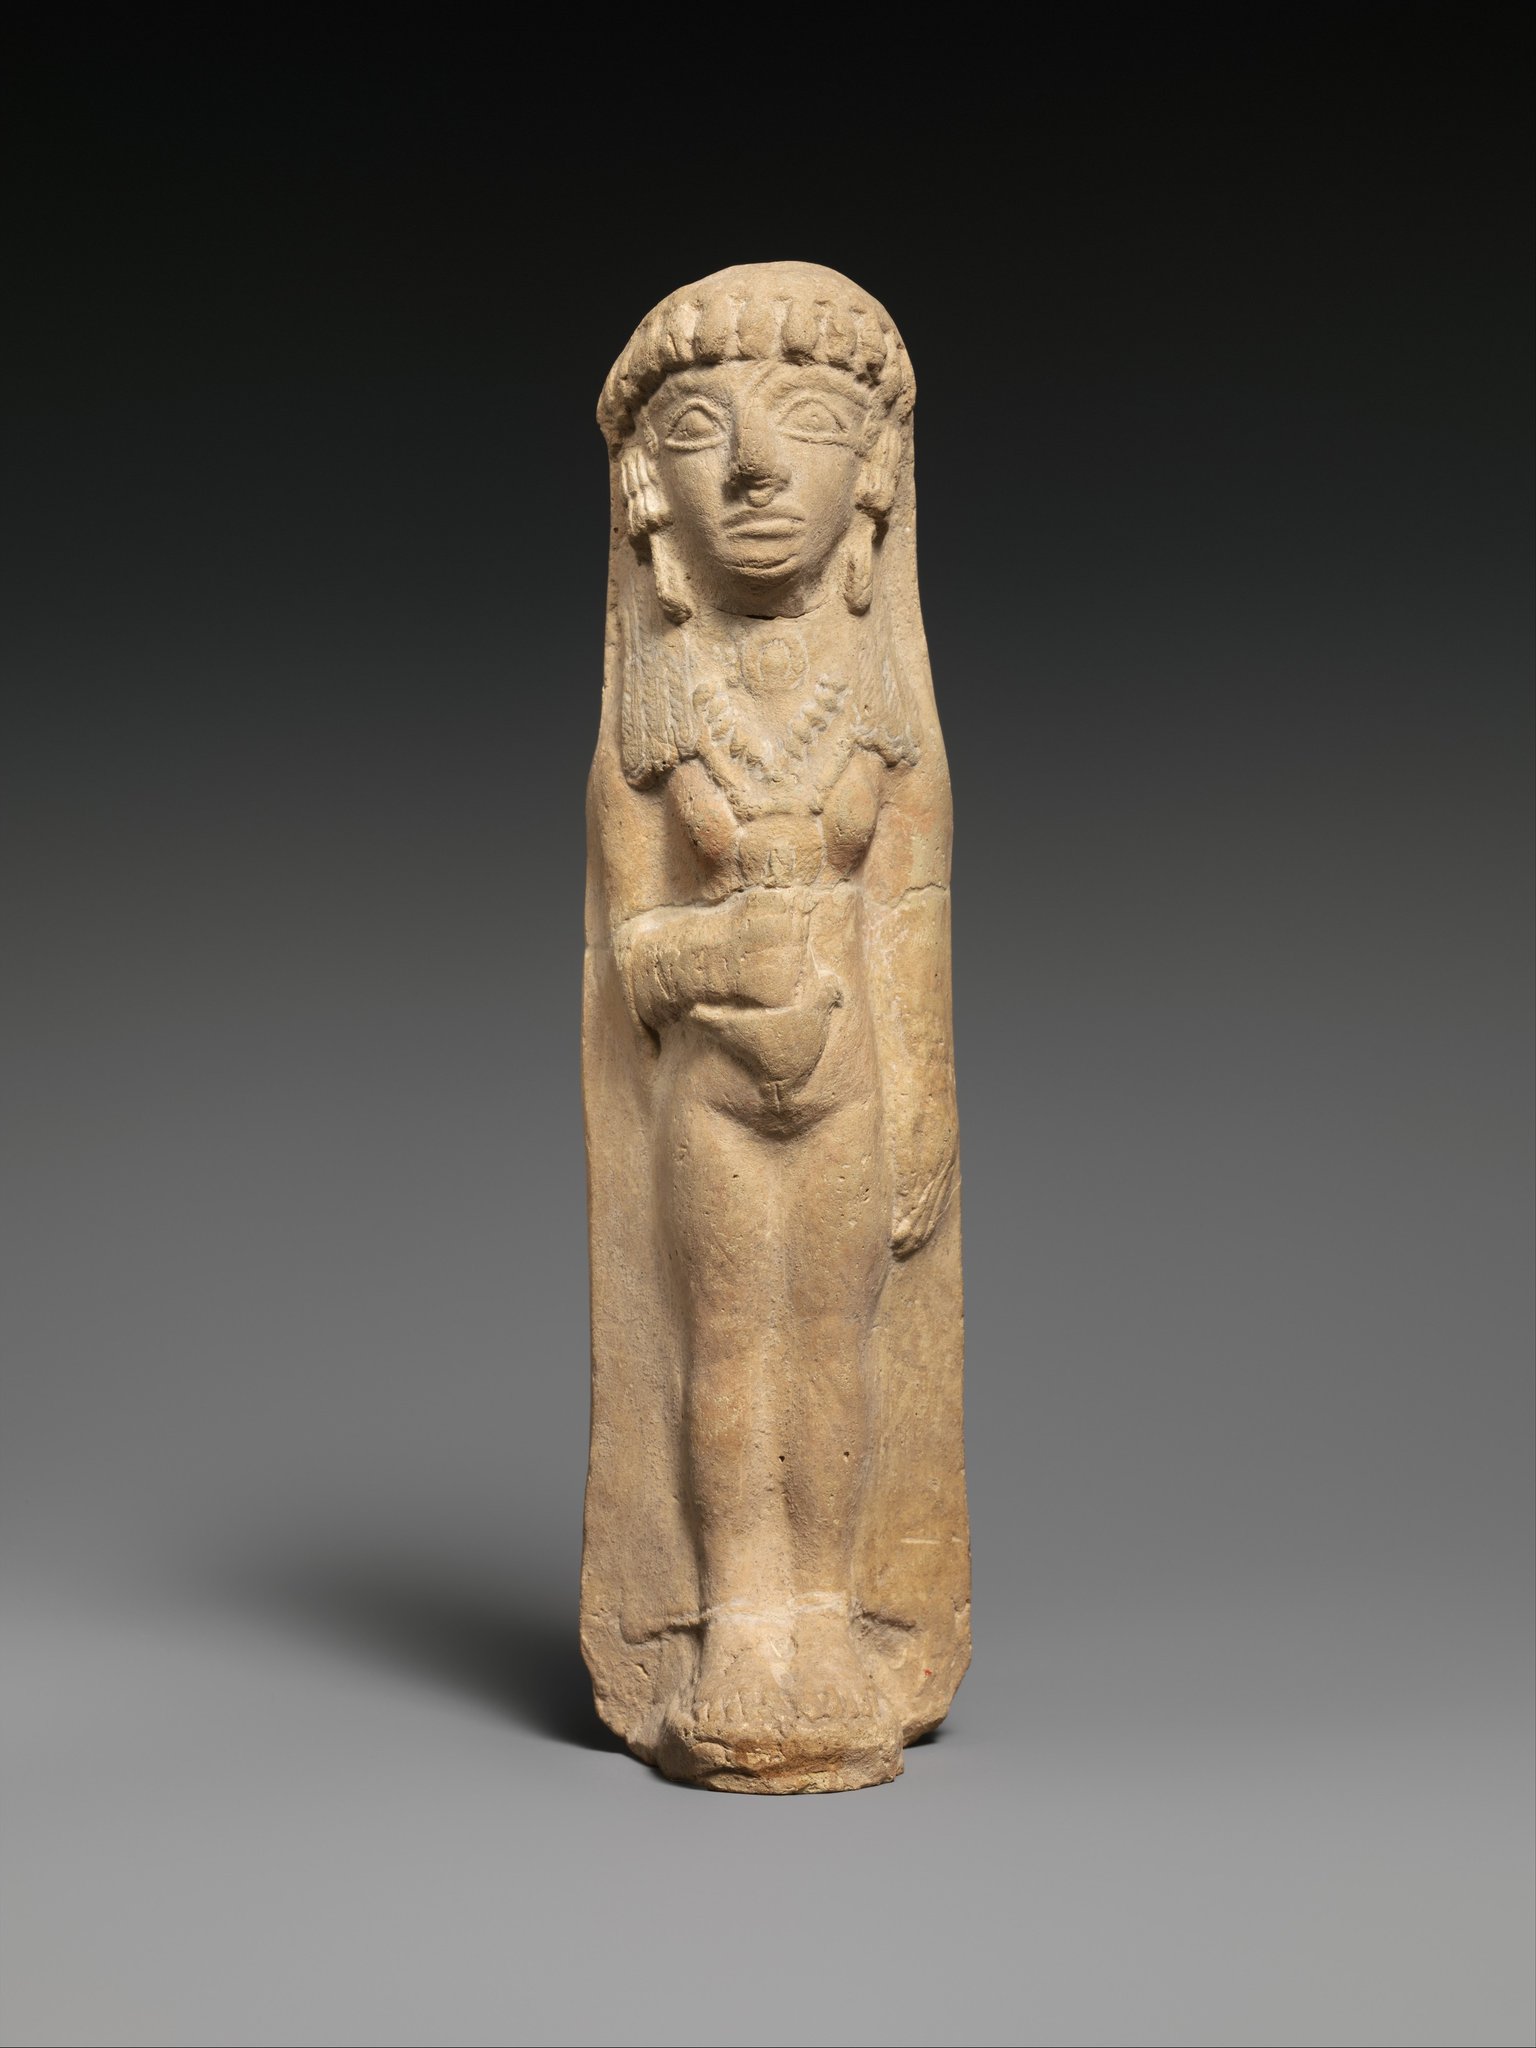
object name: statuette of a woman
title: Terracotta woman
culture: cypriot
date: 600-480 BCE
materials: terracotta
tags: birds,earrings,necklaces,pendants,women